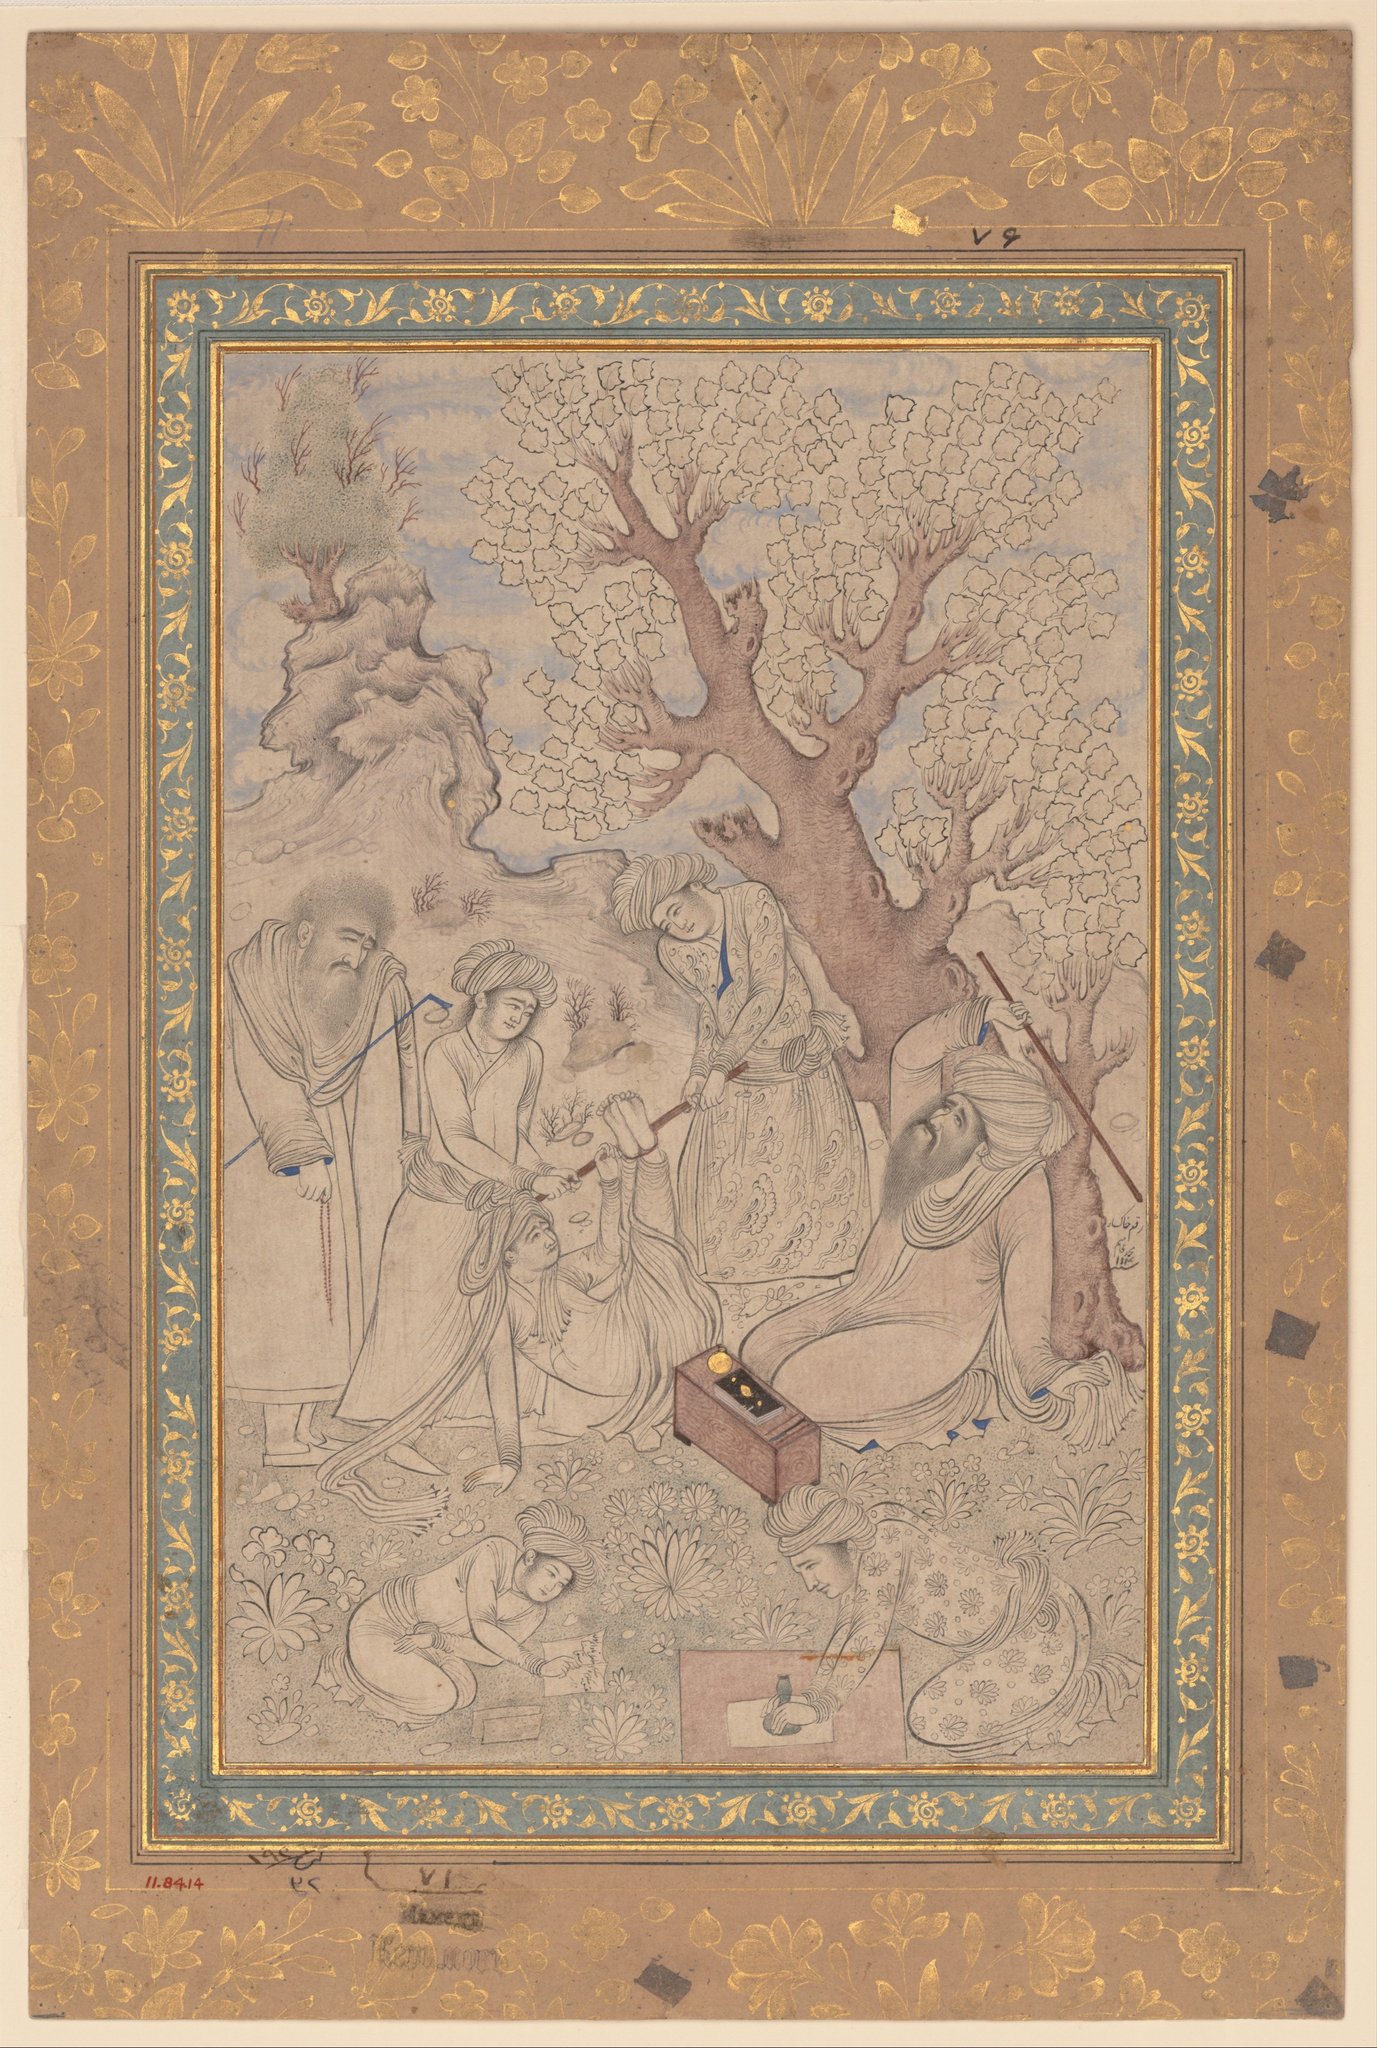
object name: album leaf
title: Chastisement of a Pupil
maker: muhammad qasim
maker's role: artist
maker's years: 1575-1684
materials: gold, ink, paper, watercolor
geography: iran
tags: men,students,punishment